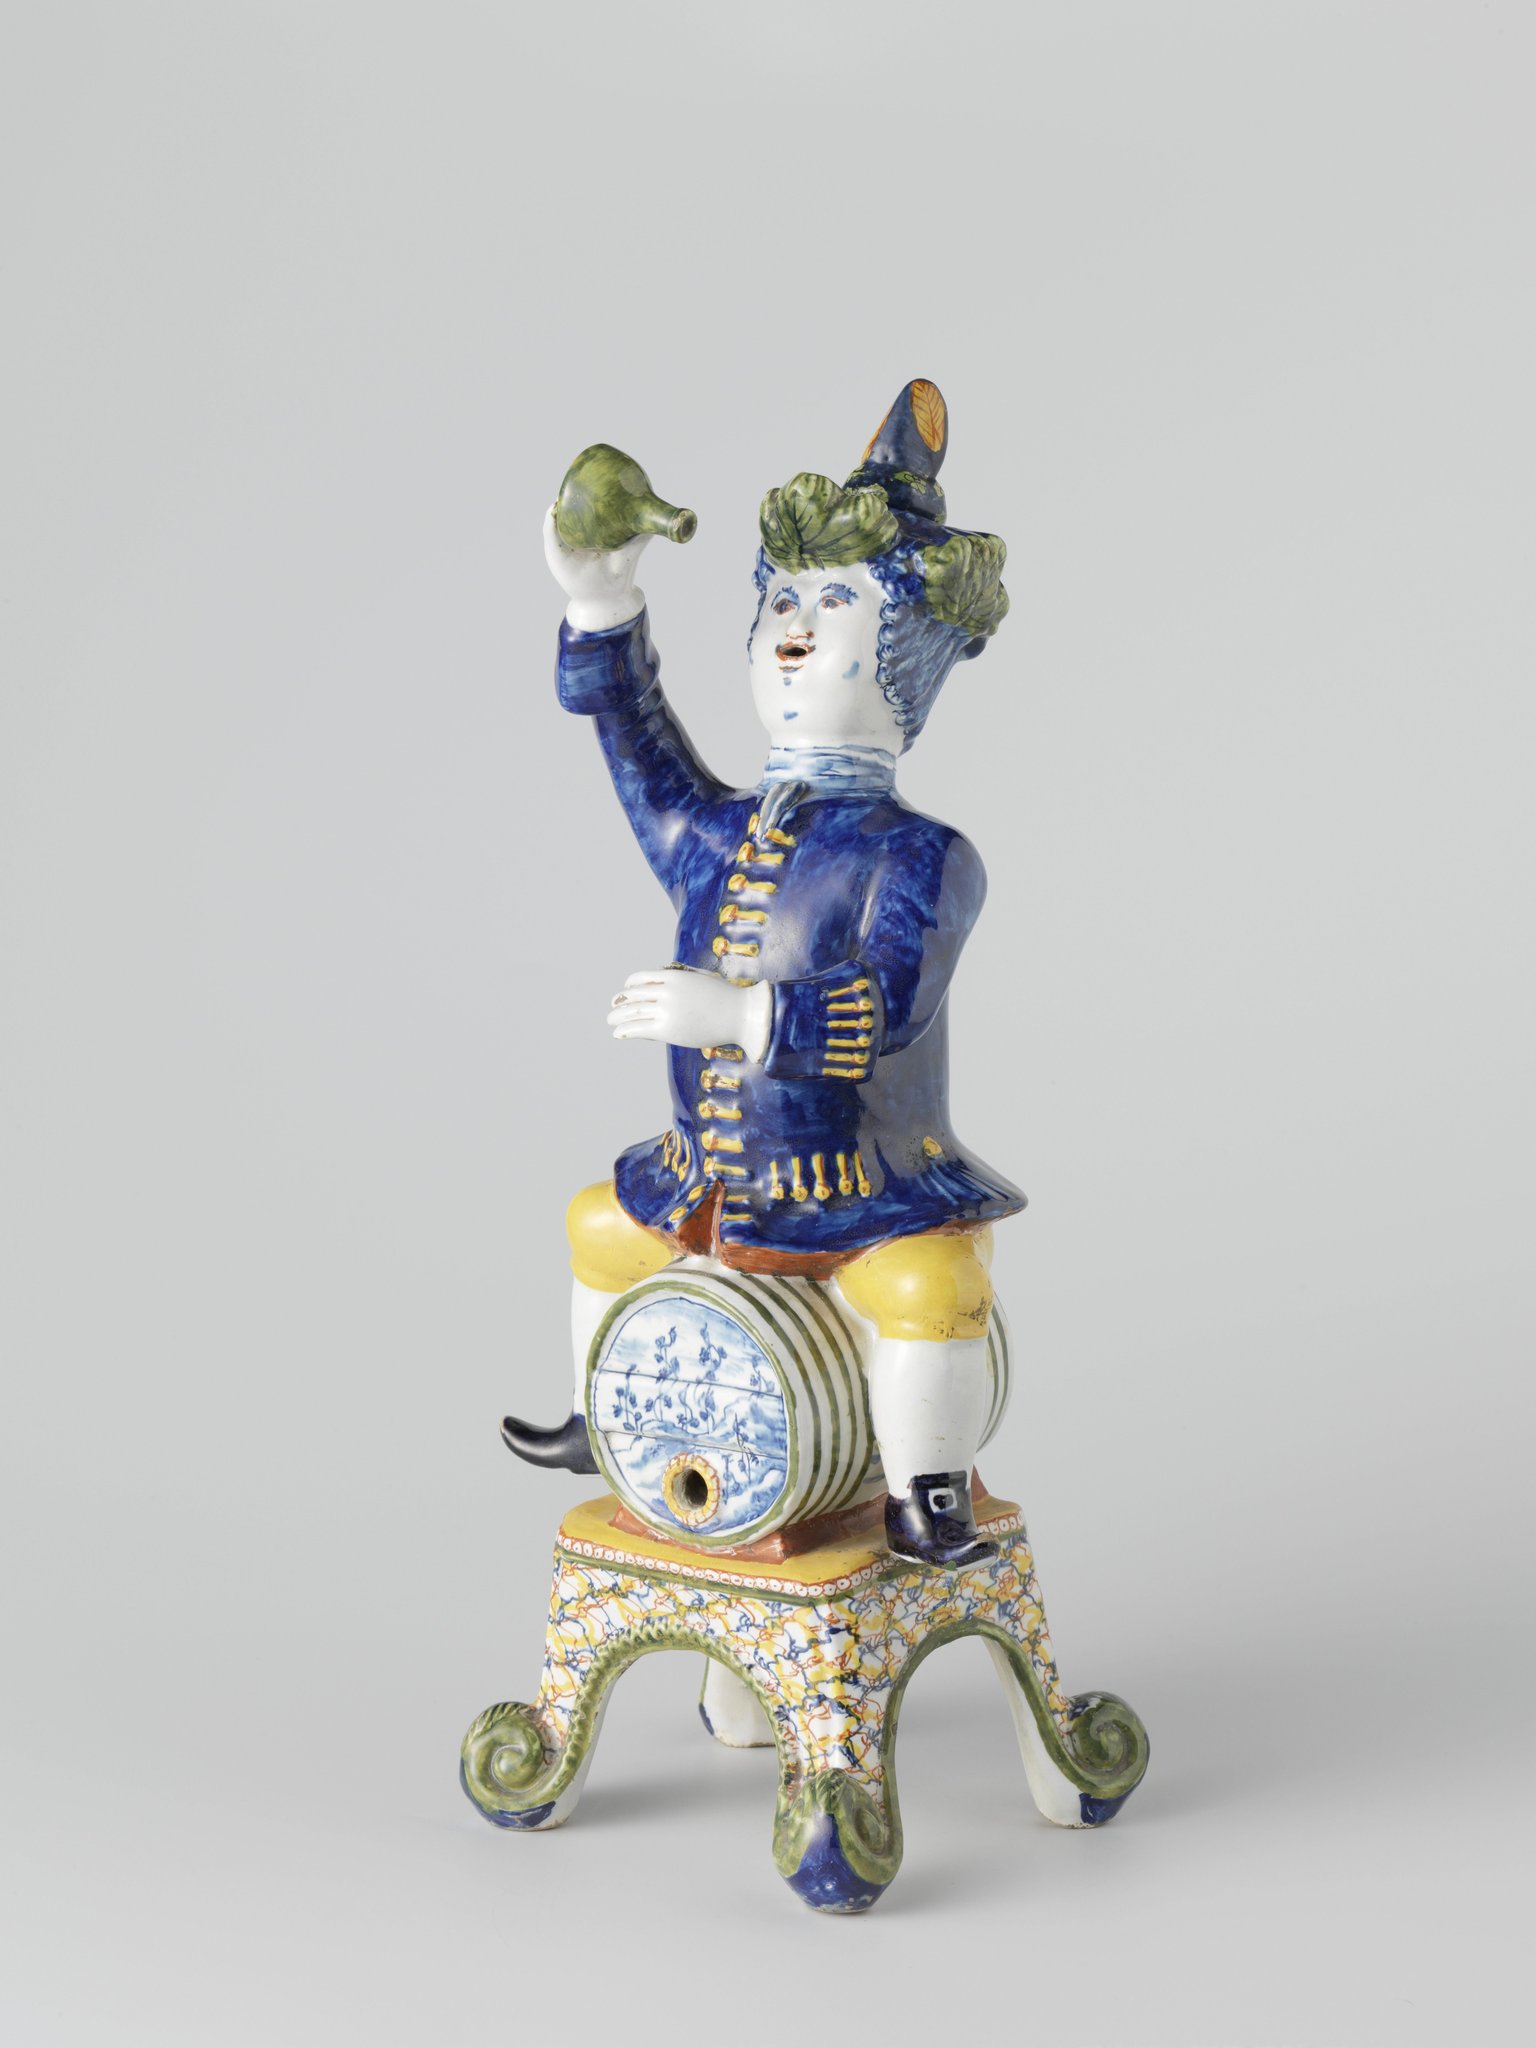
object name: decoratief object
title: Deksel van decoratief object: man met fles in hand, op ton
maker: Anonymous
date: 1760-1790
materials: earthenware, glaze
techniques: painted, polychromy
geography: delft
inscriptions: inscription: ‘no 8’, collector's mark: ‘collection JF Loudon’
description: Deksel van decoratief object van veelkleurig beschilderde faïence.